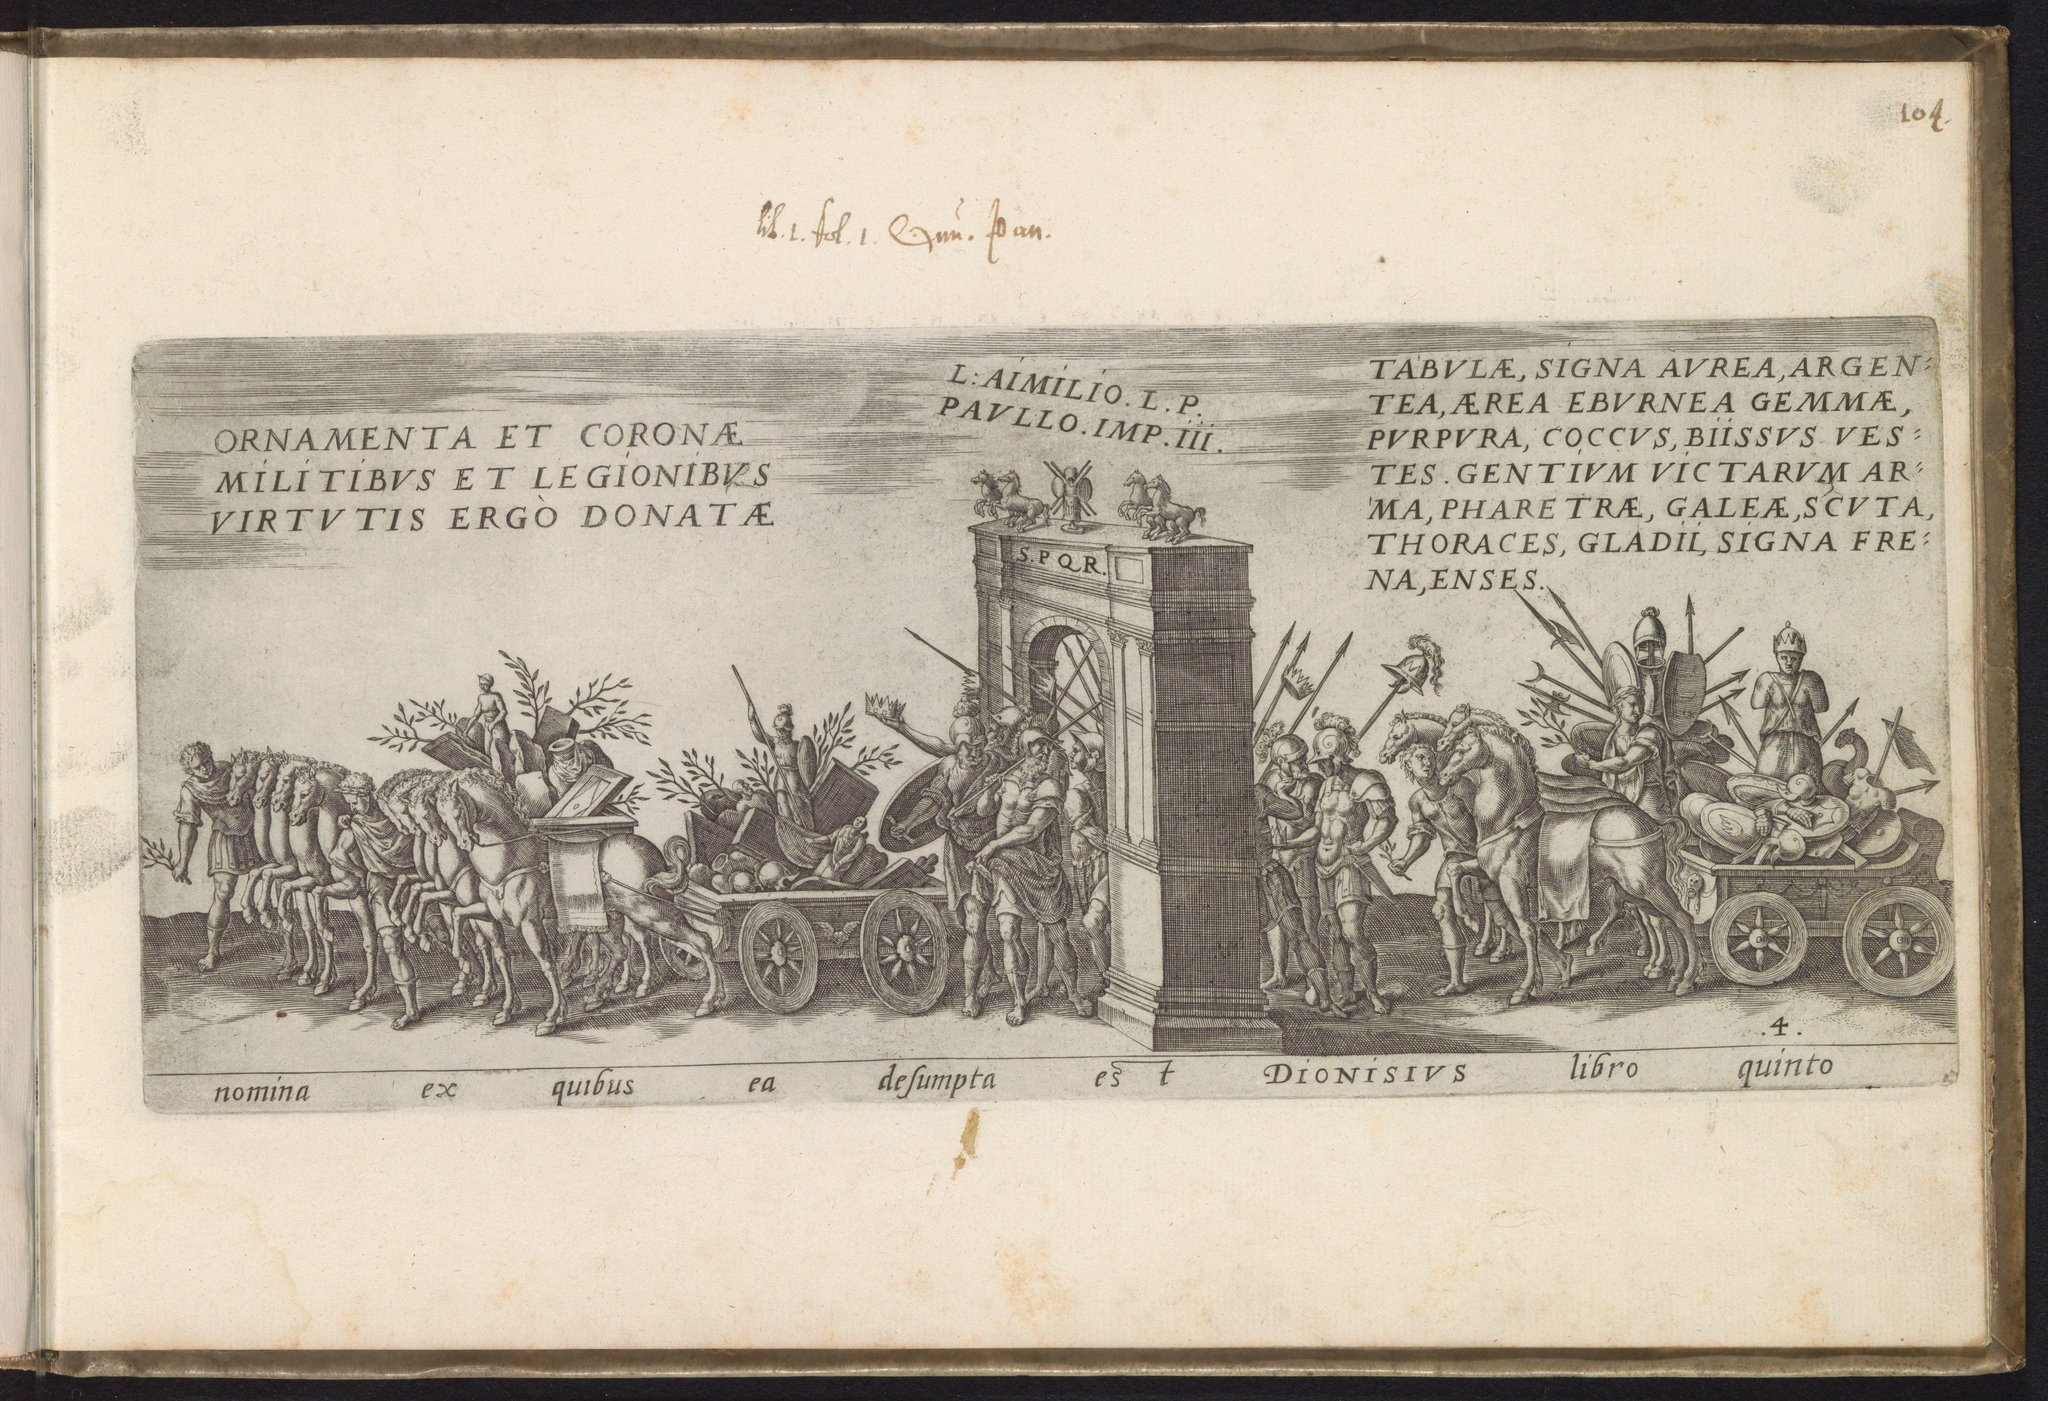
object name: album leaf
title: Nomina ex quibus ea desumpta est Dionisius libro quinto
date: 1618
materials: paper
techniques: engraving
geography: italy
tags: ceremonial procession, parade, pageant ~ installation of a ruler, triumphal arch, carrying off the spoils of war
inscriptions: inscription: ‘lib. 1. fol. 1 [...]’, number: ‘104’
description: Processie van wagens met oorlogsbuit die worden voortgetrokken door paarden. De processie gaat onder een triomfboog door. Titel in het Latijn in ondermarge. Prent maakt deel uit van een album.